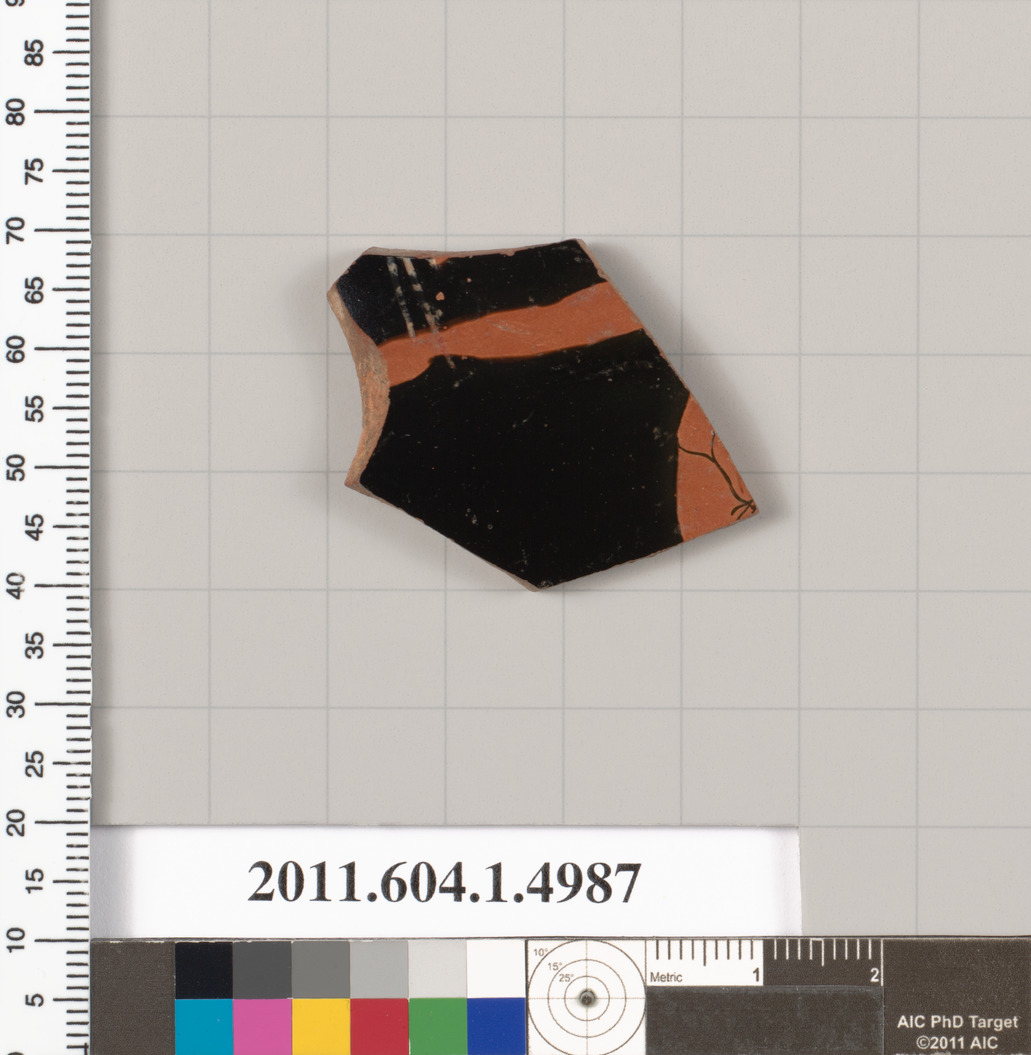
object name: kylix fragment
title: Terracotta fragment of a kylix (drinking cup)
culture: greek, attic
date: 475-451 BCE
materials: terracotta